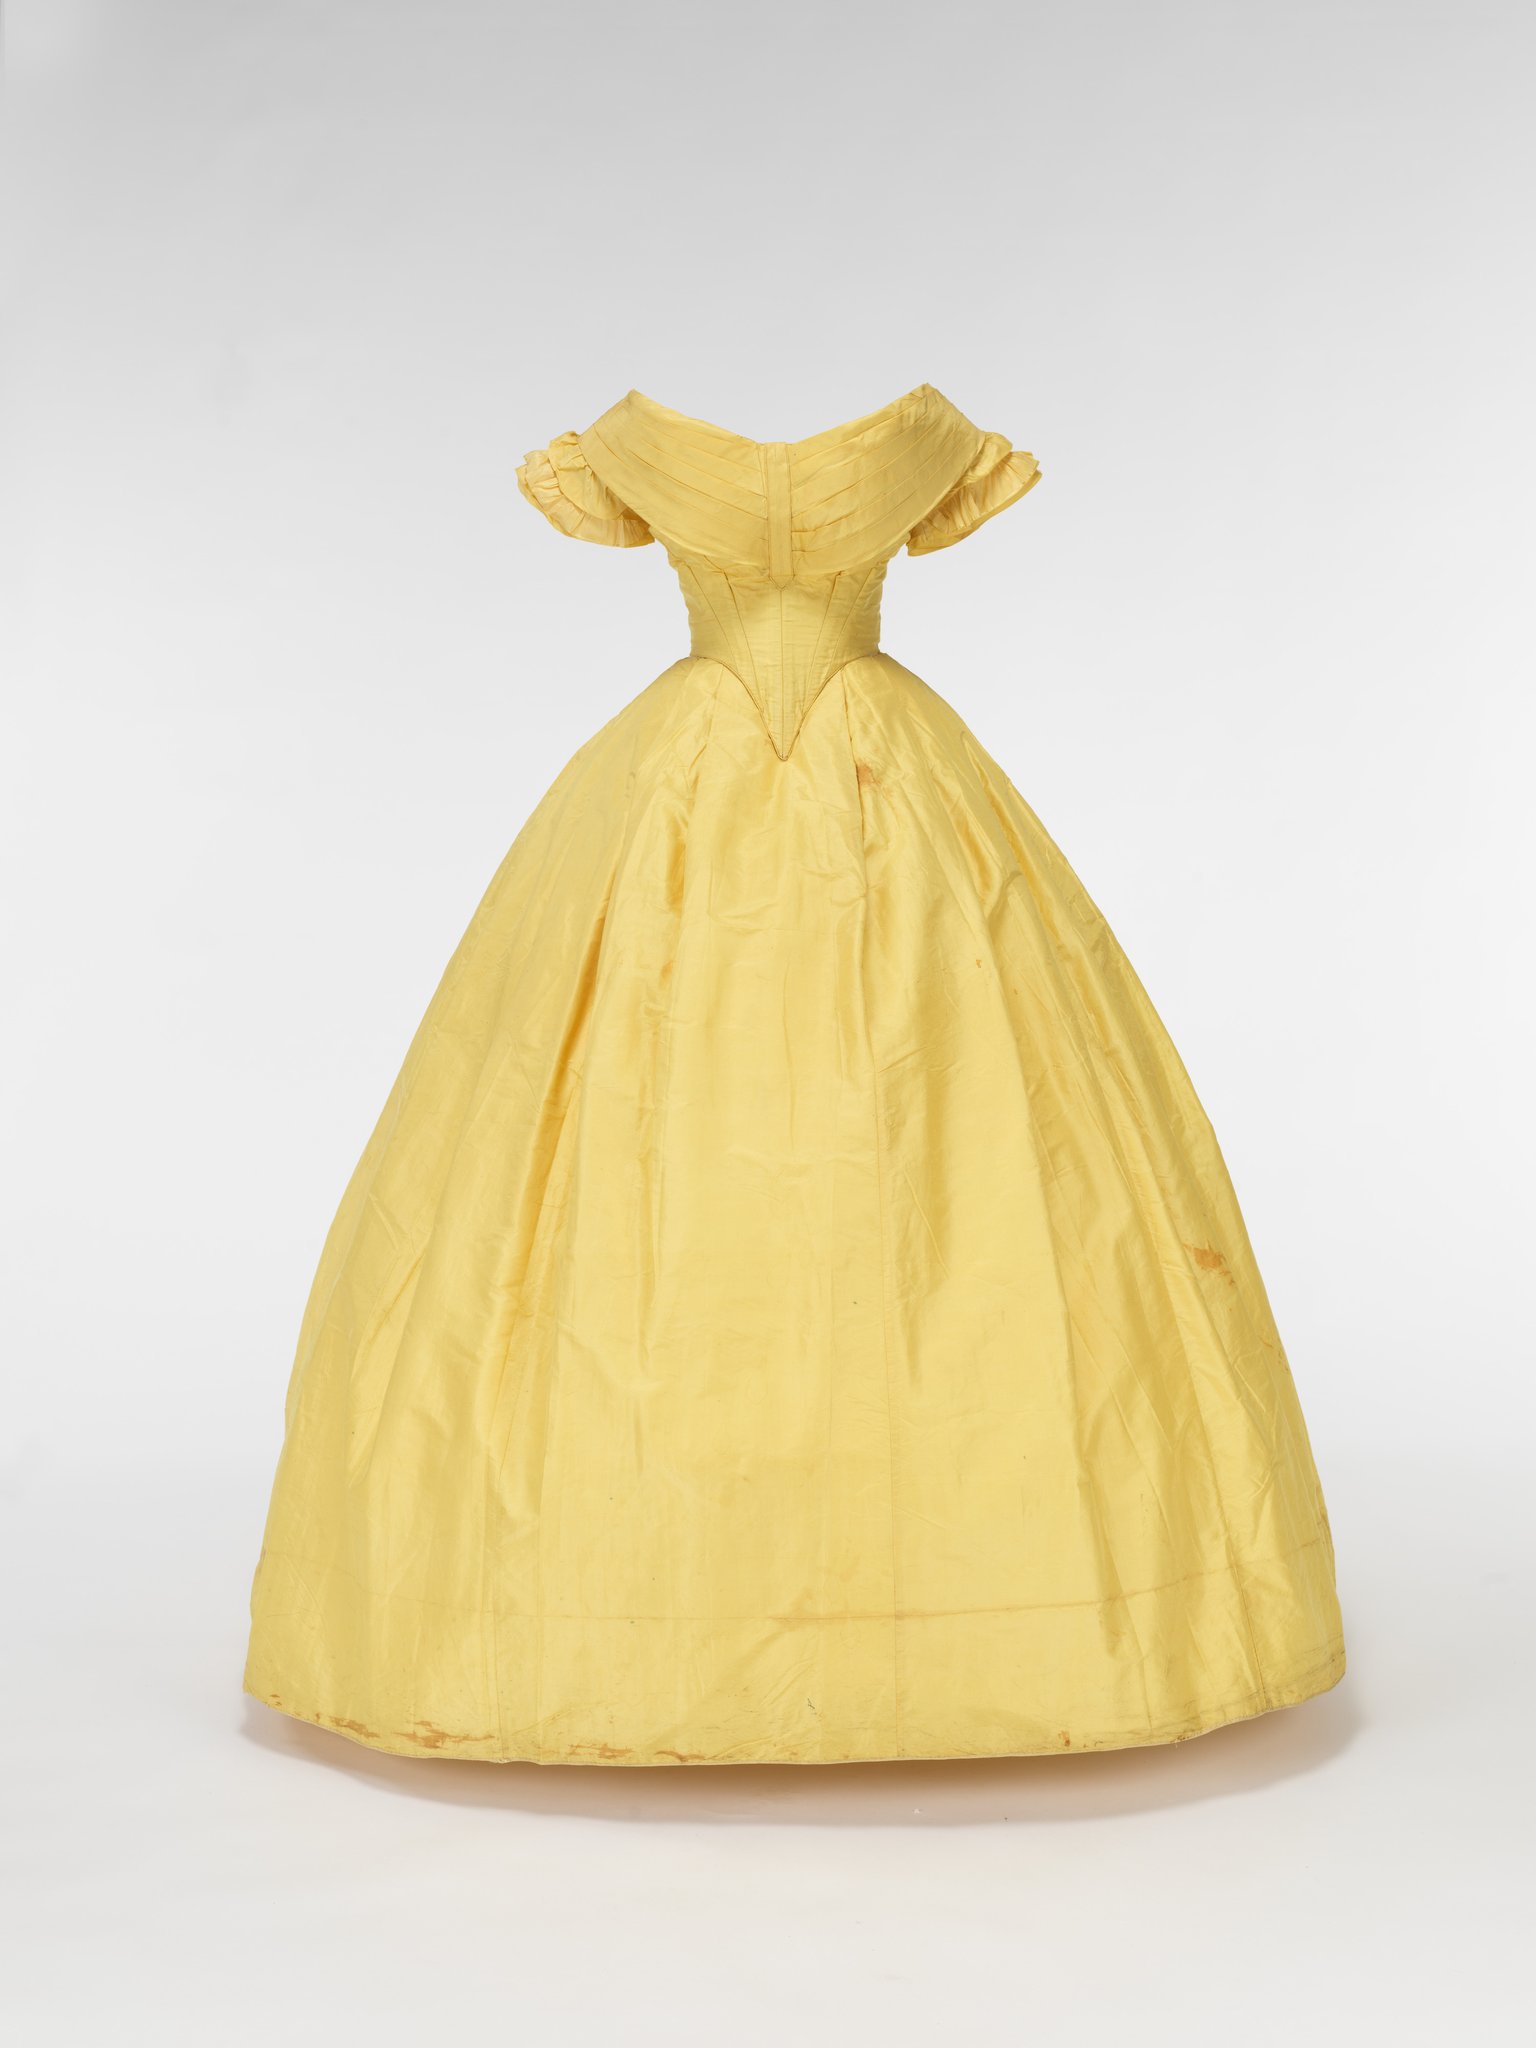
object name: dress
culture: american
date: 1834-1866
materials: silk